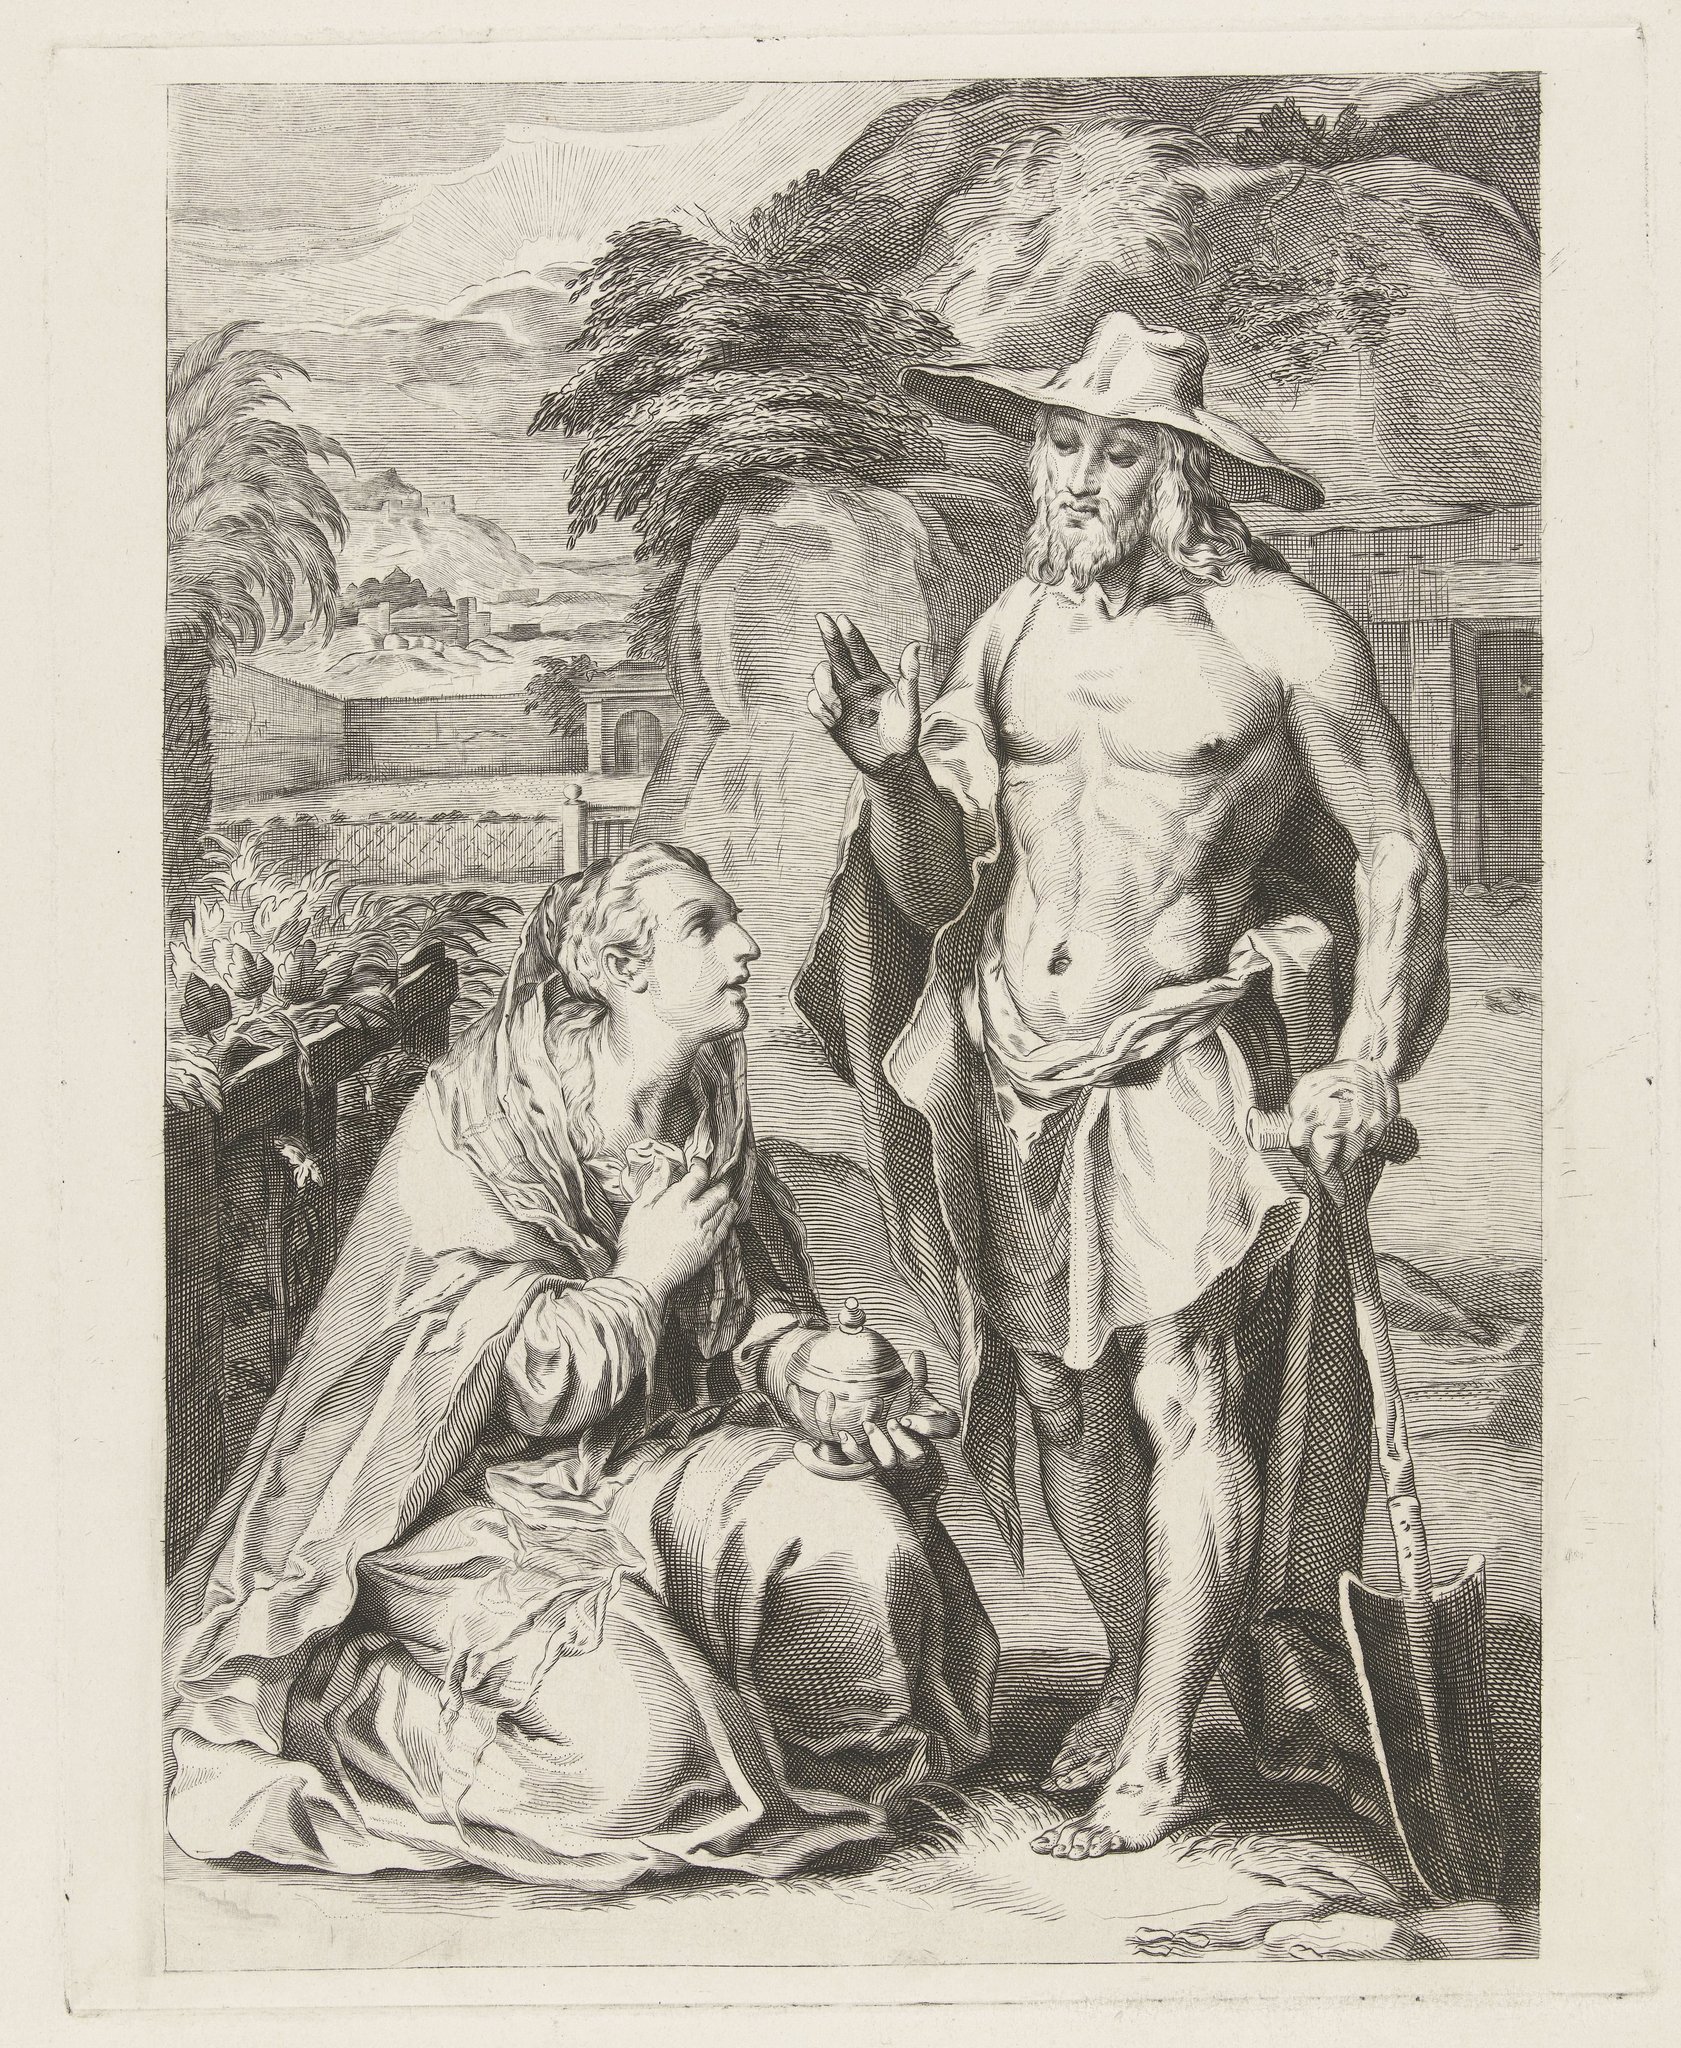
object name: print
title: Noli me tangere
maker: petrus johannes arendzen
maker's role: draughtsman, print maker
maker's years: 1846-1932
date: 1864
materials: paper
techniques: engraving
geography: netherlands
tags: mary magdalene kneeling before christ, who is usually represented as a gardener with a hoe and/or a spade; 'noli me tangere'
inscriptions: inscription: ‘PJ Arendzen 20 Februari 1864’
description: kopie naar Jacob Matham, naar H. Goltzius Bartsch 103/Hollstein 62